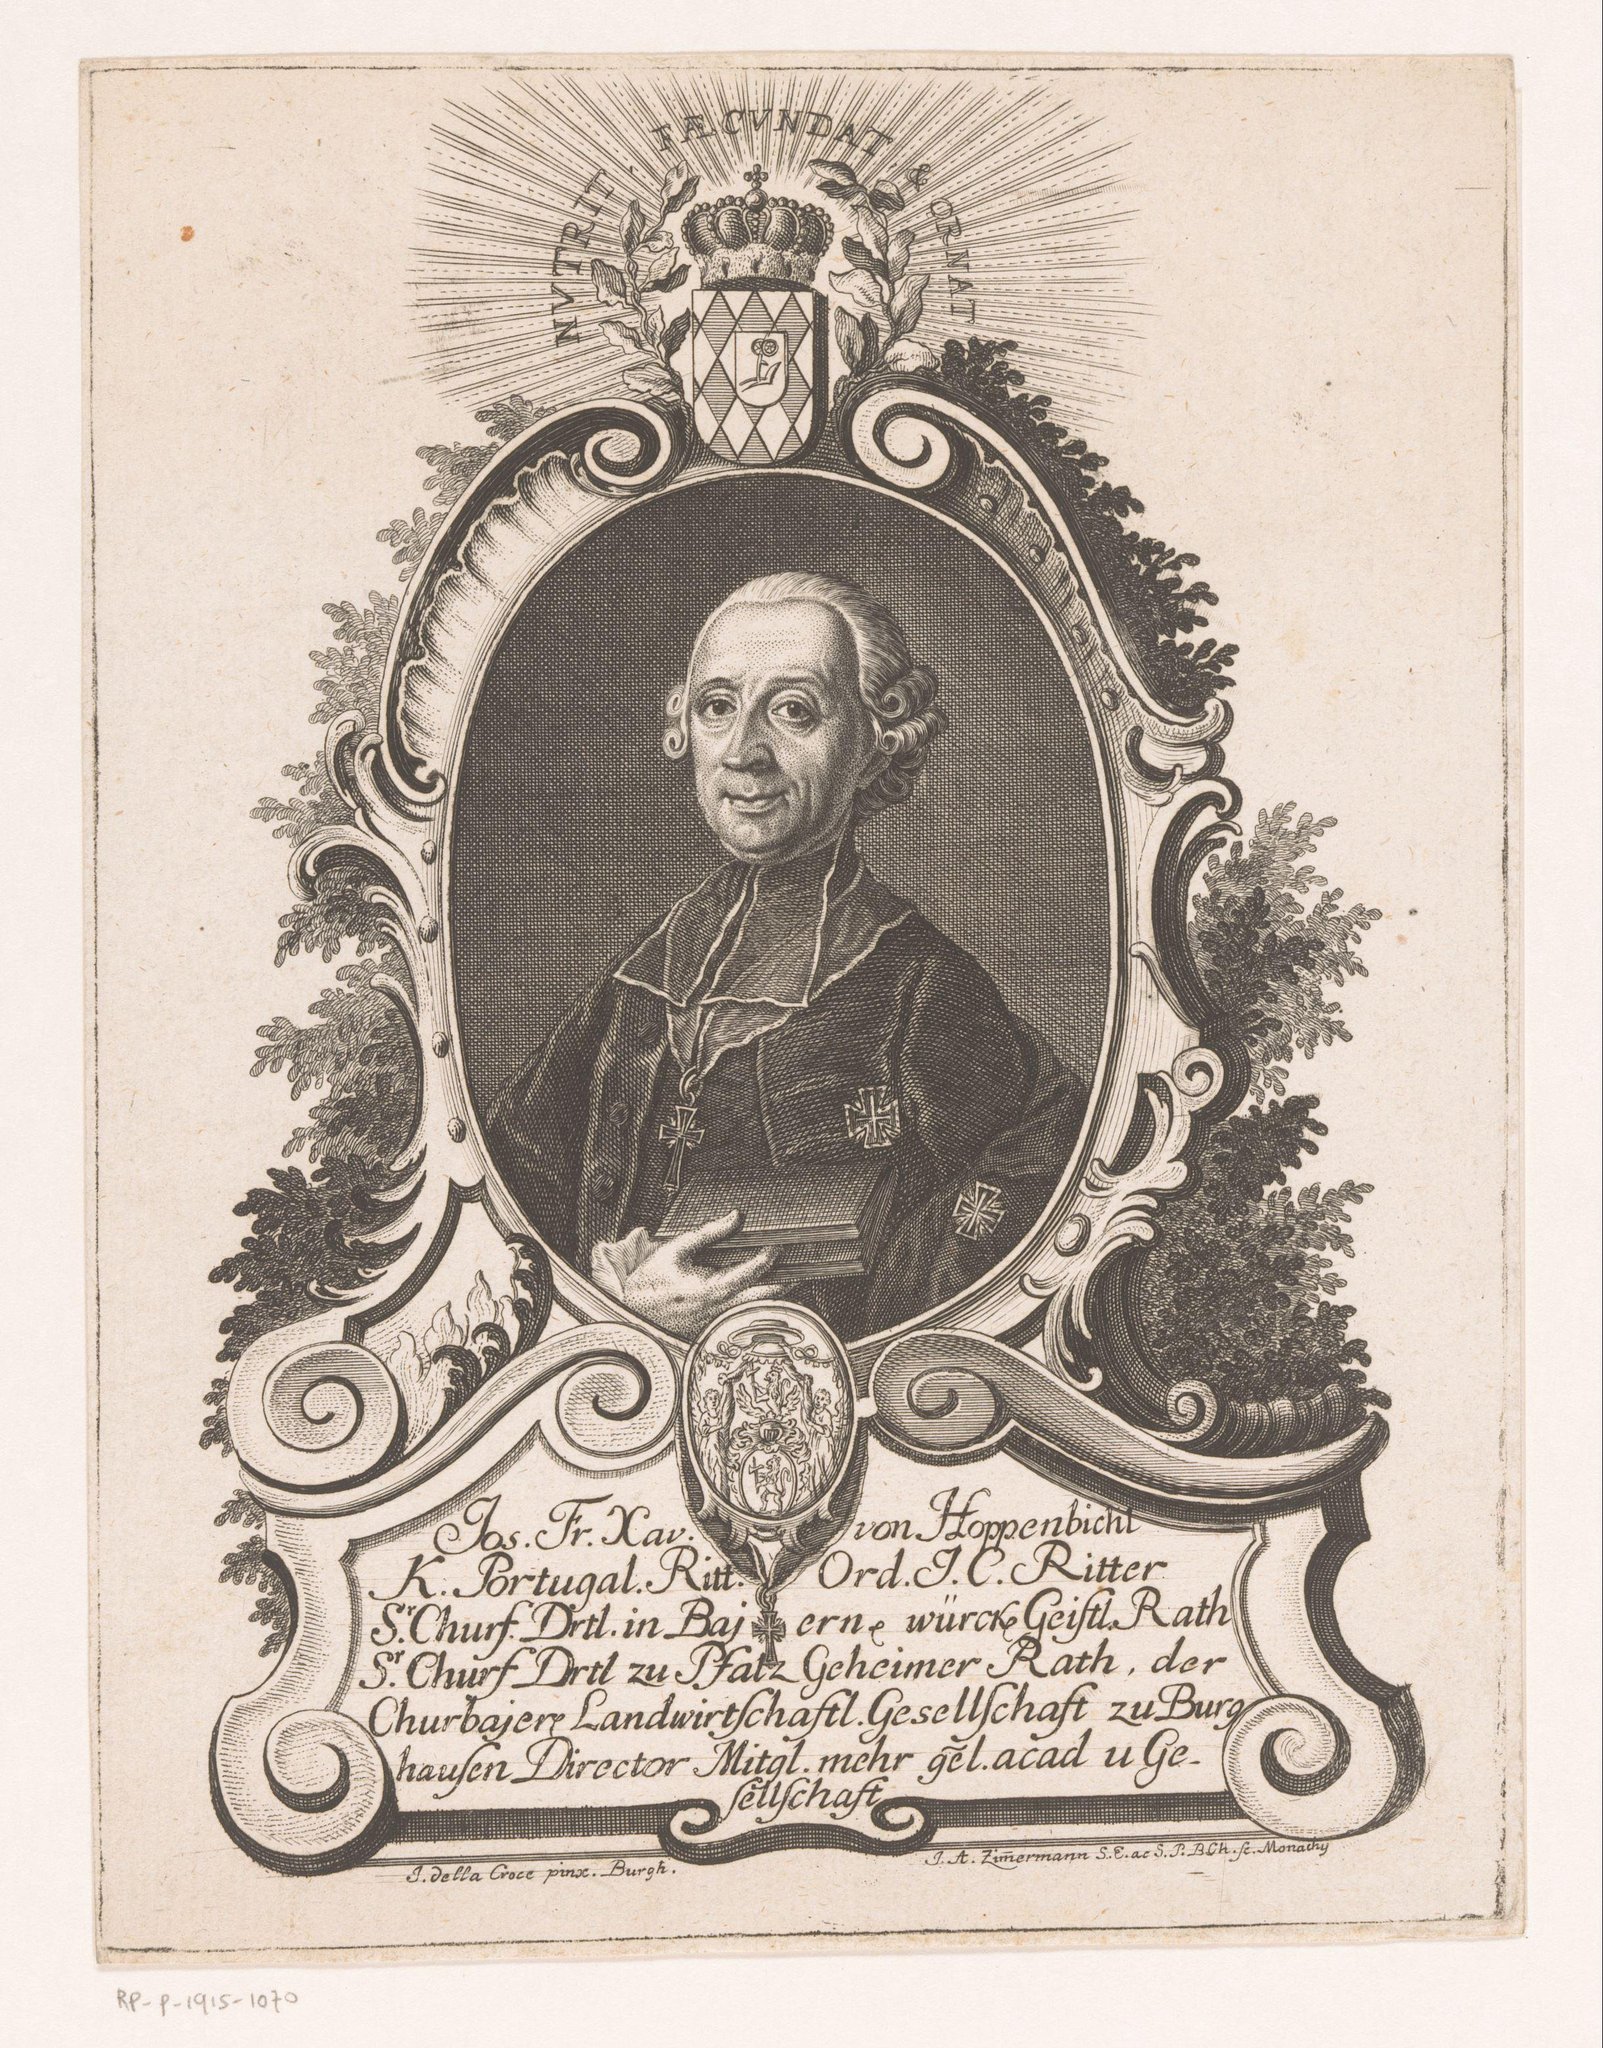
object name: print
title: Portret van Franz Xaver von Hoppenbichl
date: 1746-1797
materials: paper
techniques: engraving, etching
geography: burghausen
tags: clergyman, historical persons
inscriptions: collector's mark: Lugt 2228